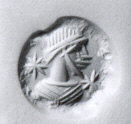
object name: stamp seal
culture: sasanian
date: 401-700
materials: stone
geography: iran